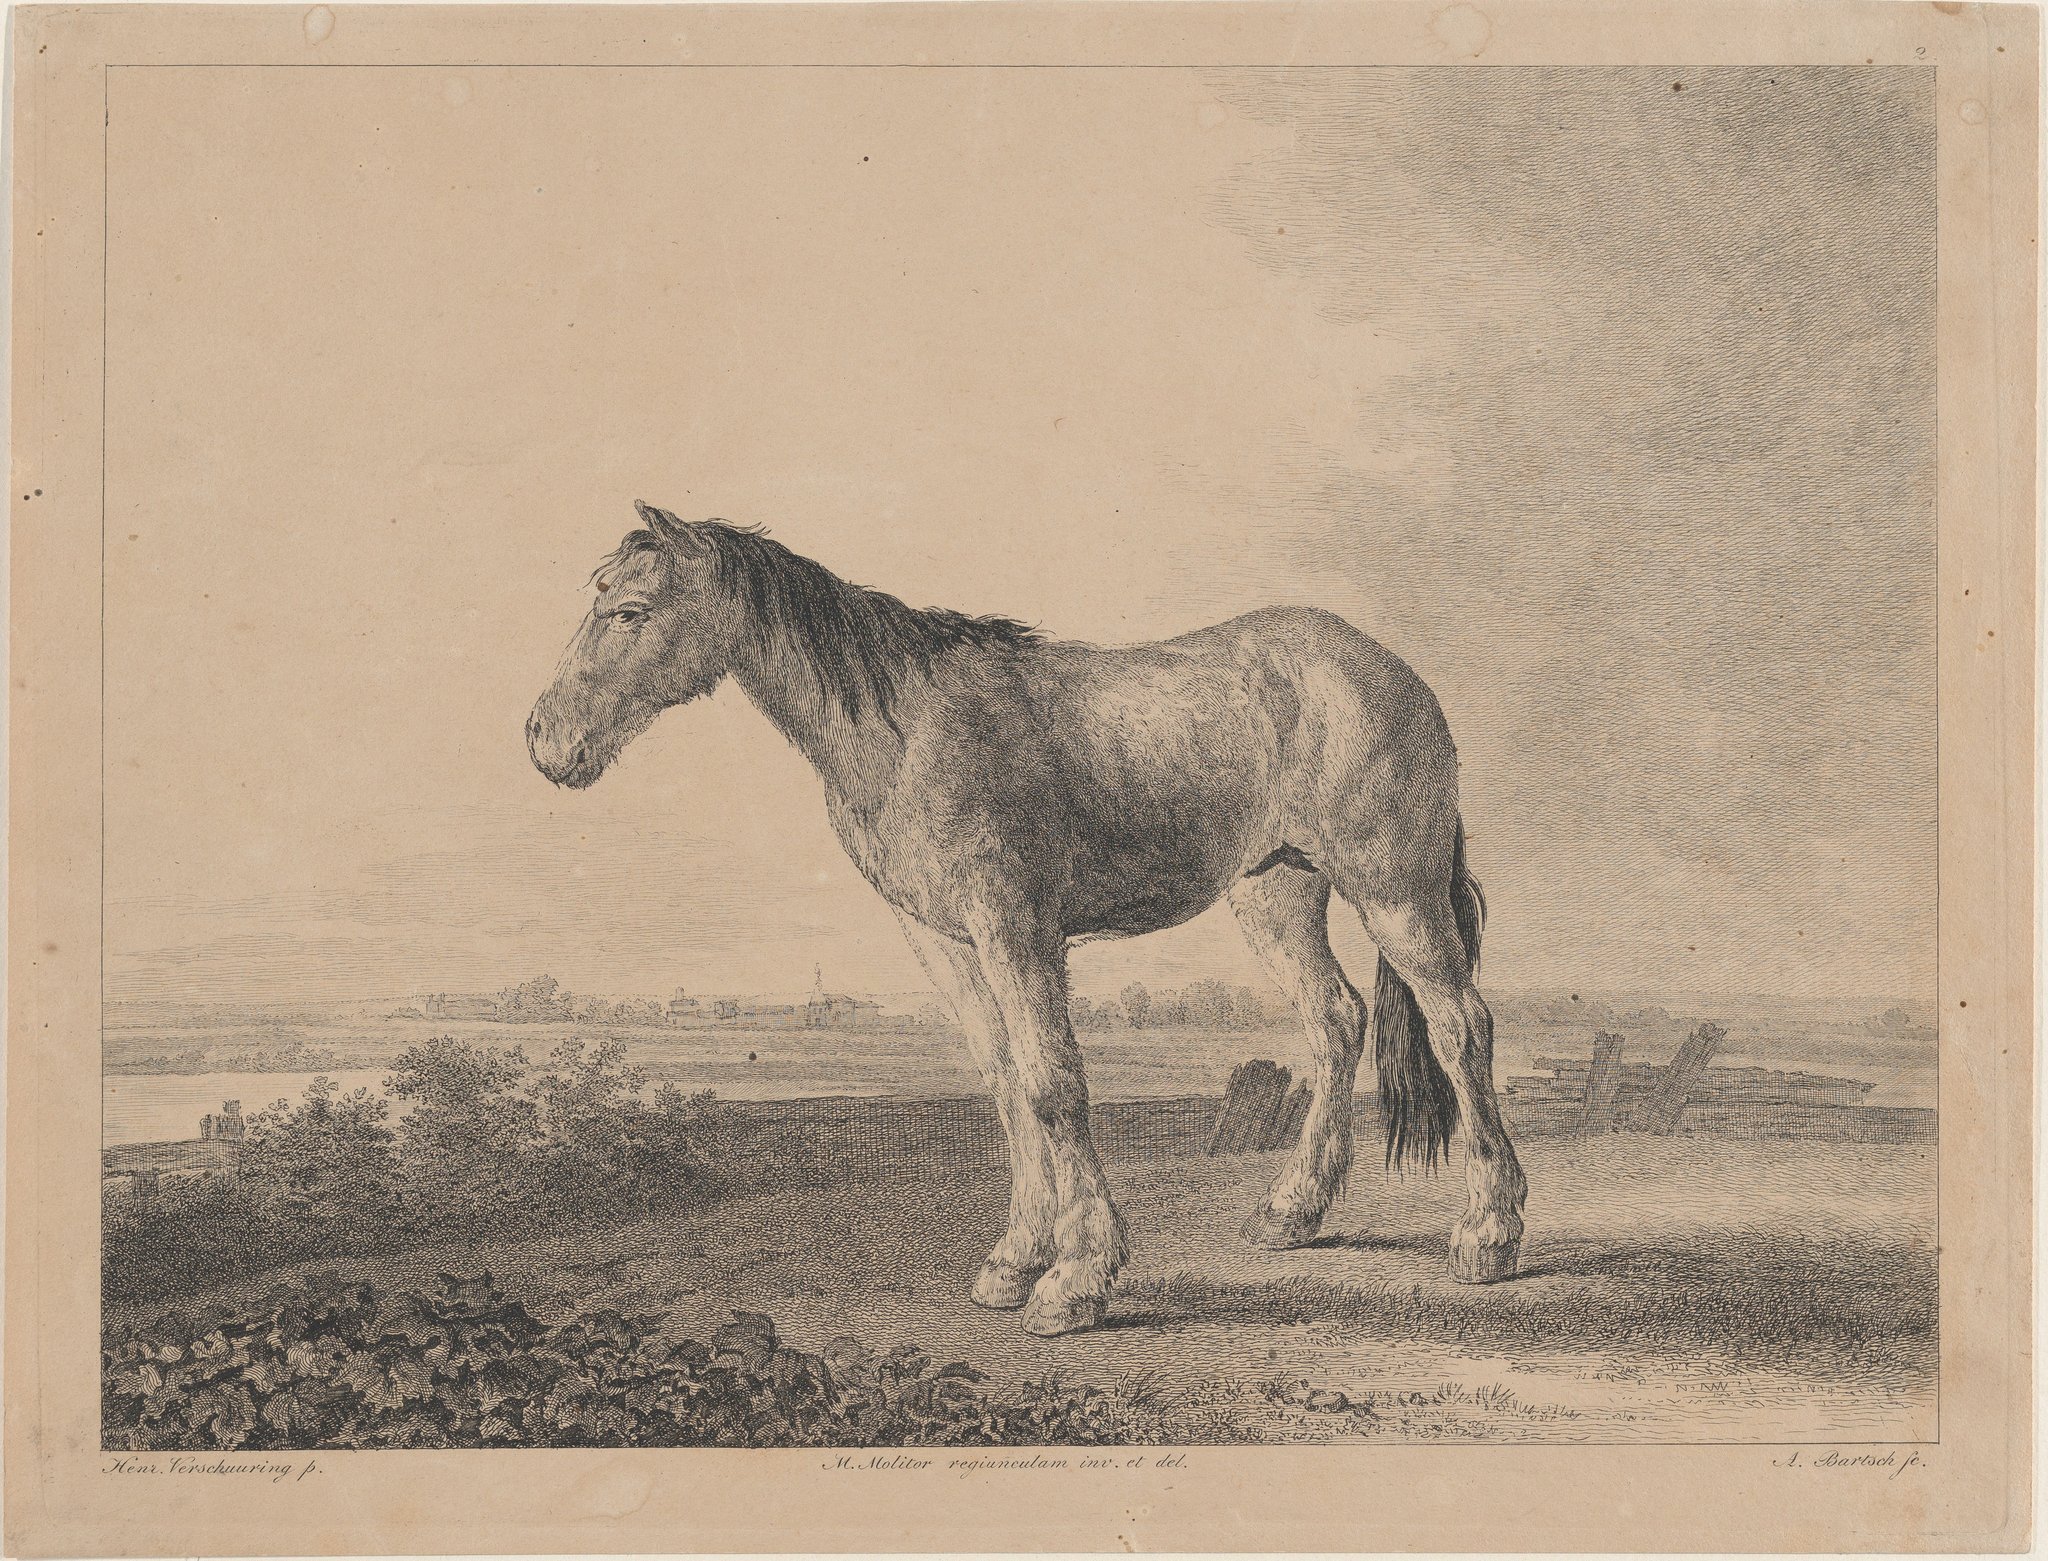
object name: print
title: Horse standing on a field in profile to left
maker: adam von bartsch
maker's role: artist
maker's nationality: austrian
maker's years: 1757-1821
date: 1809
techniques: engraving, etching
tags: horses